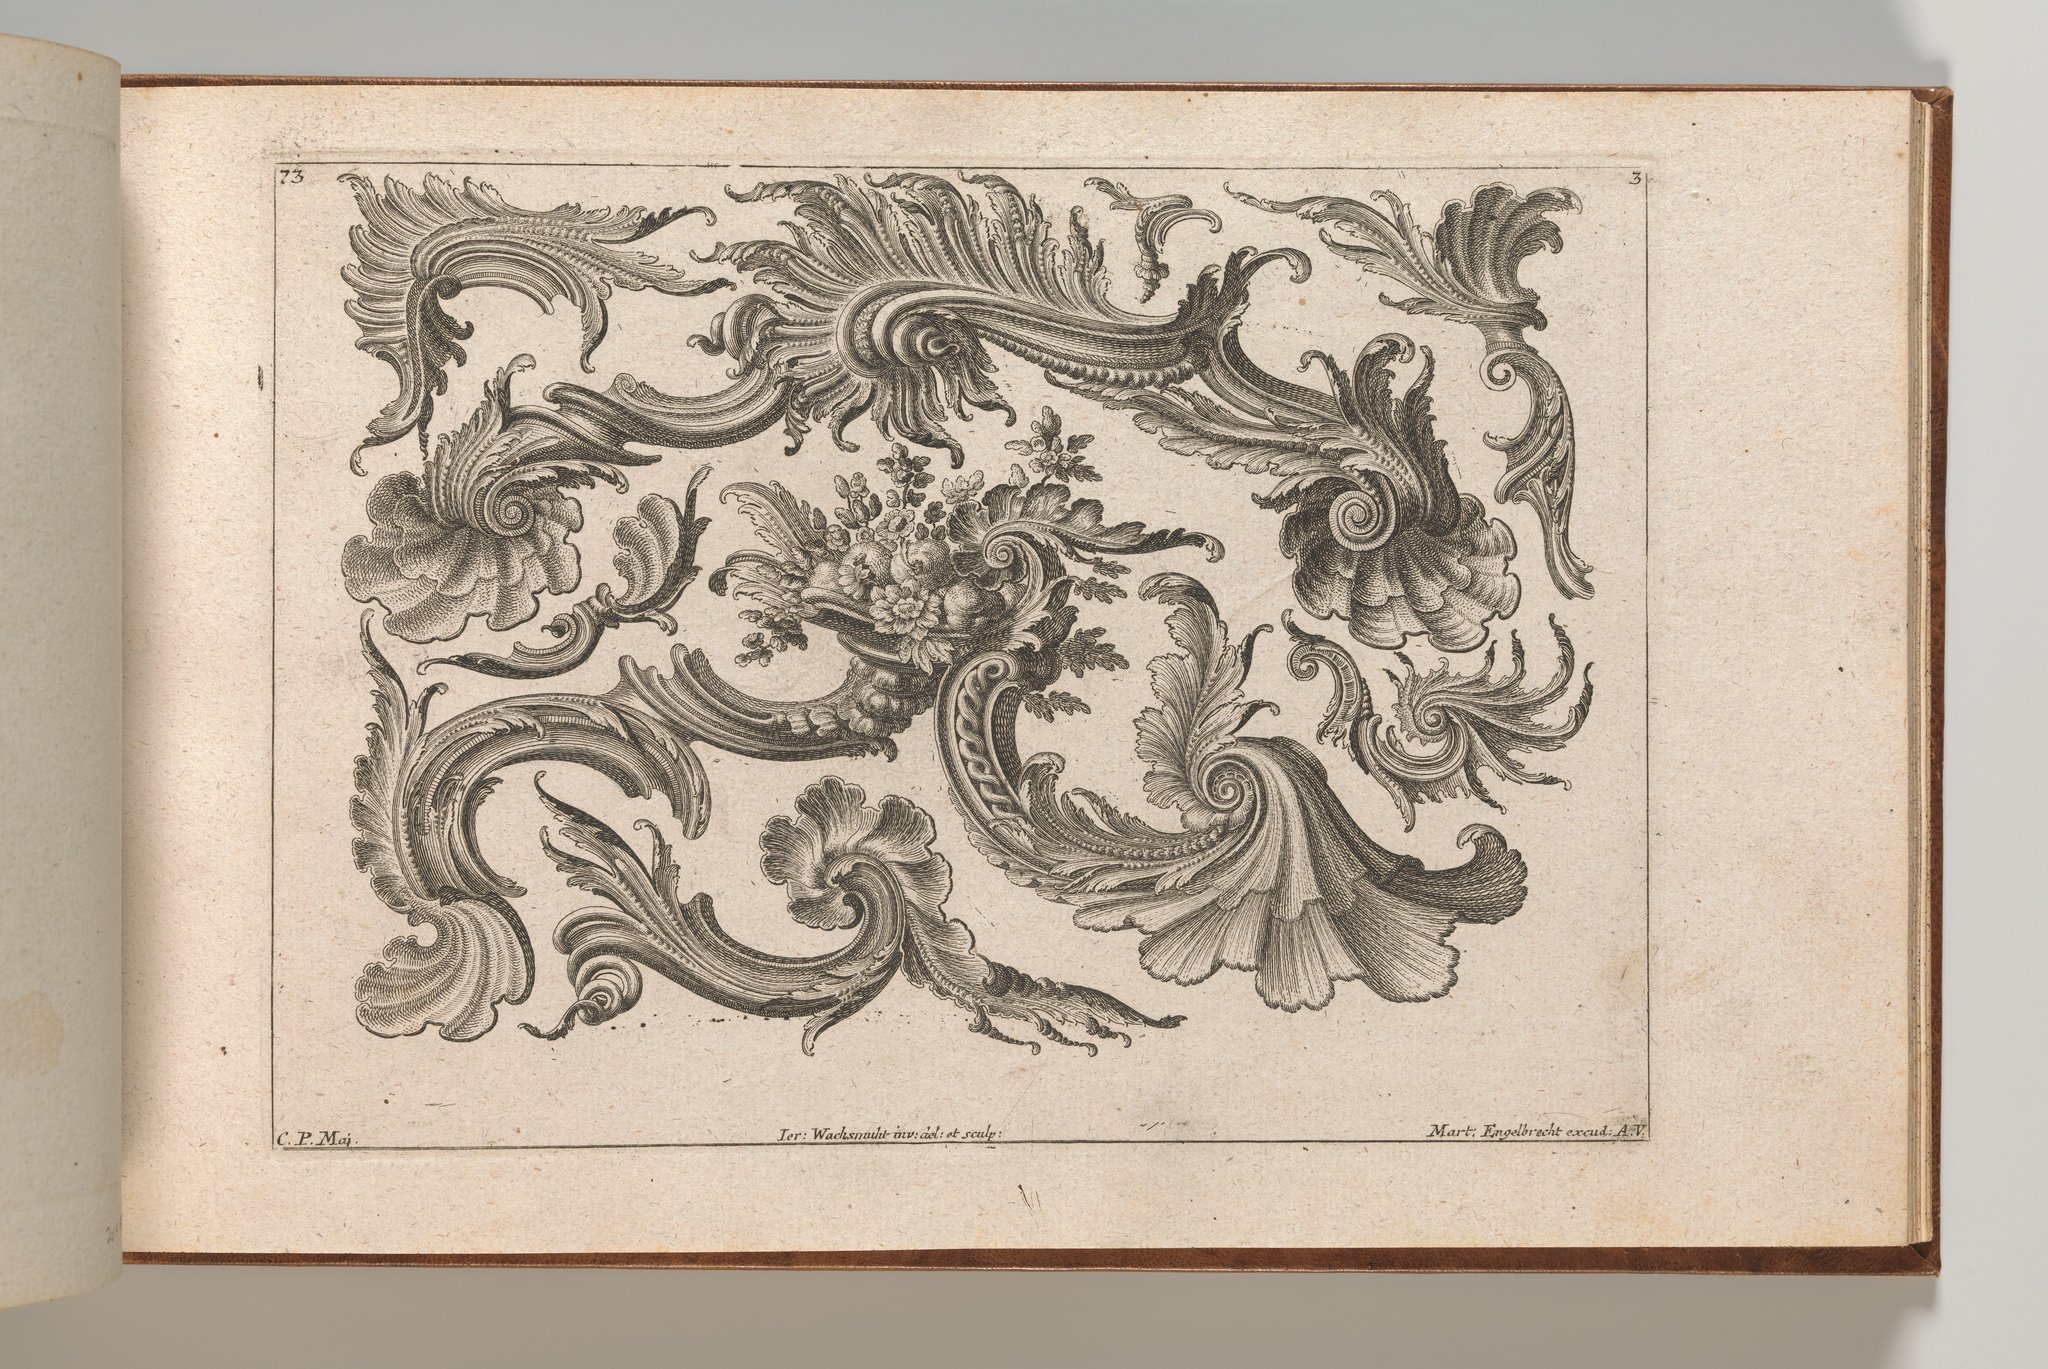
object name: album print ornament architecture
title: Various Designs for Rocaille Ornaments, Plate 3 from: 'Fortsezung von unterschielichen Auszierungen zu allerleij nüzlich anzuwenden'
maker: jeremias wachsmuth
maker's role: artist and engraver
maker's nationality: german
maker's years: 1712-1771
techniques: etching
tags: ornament,cornucopia